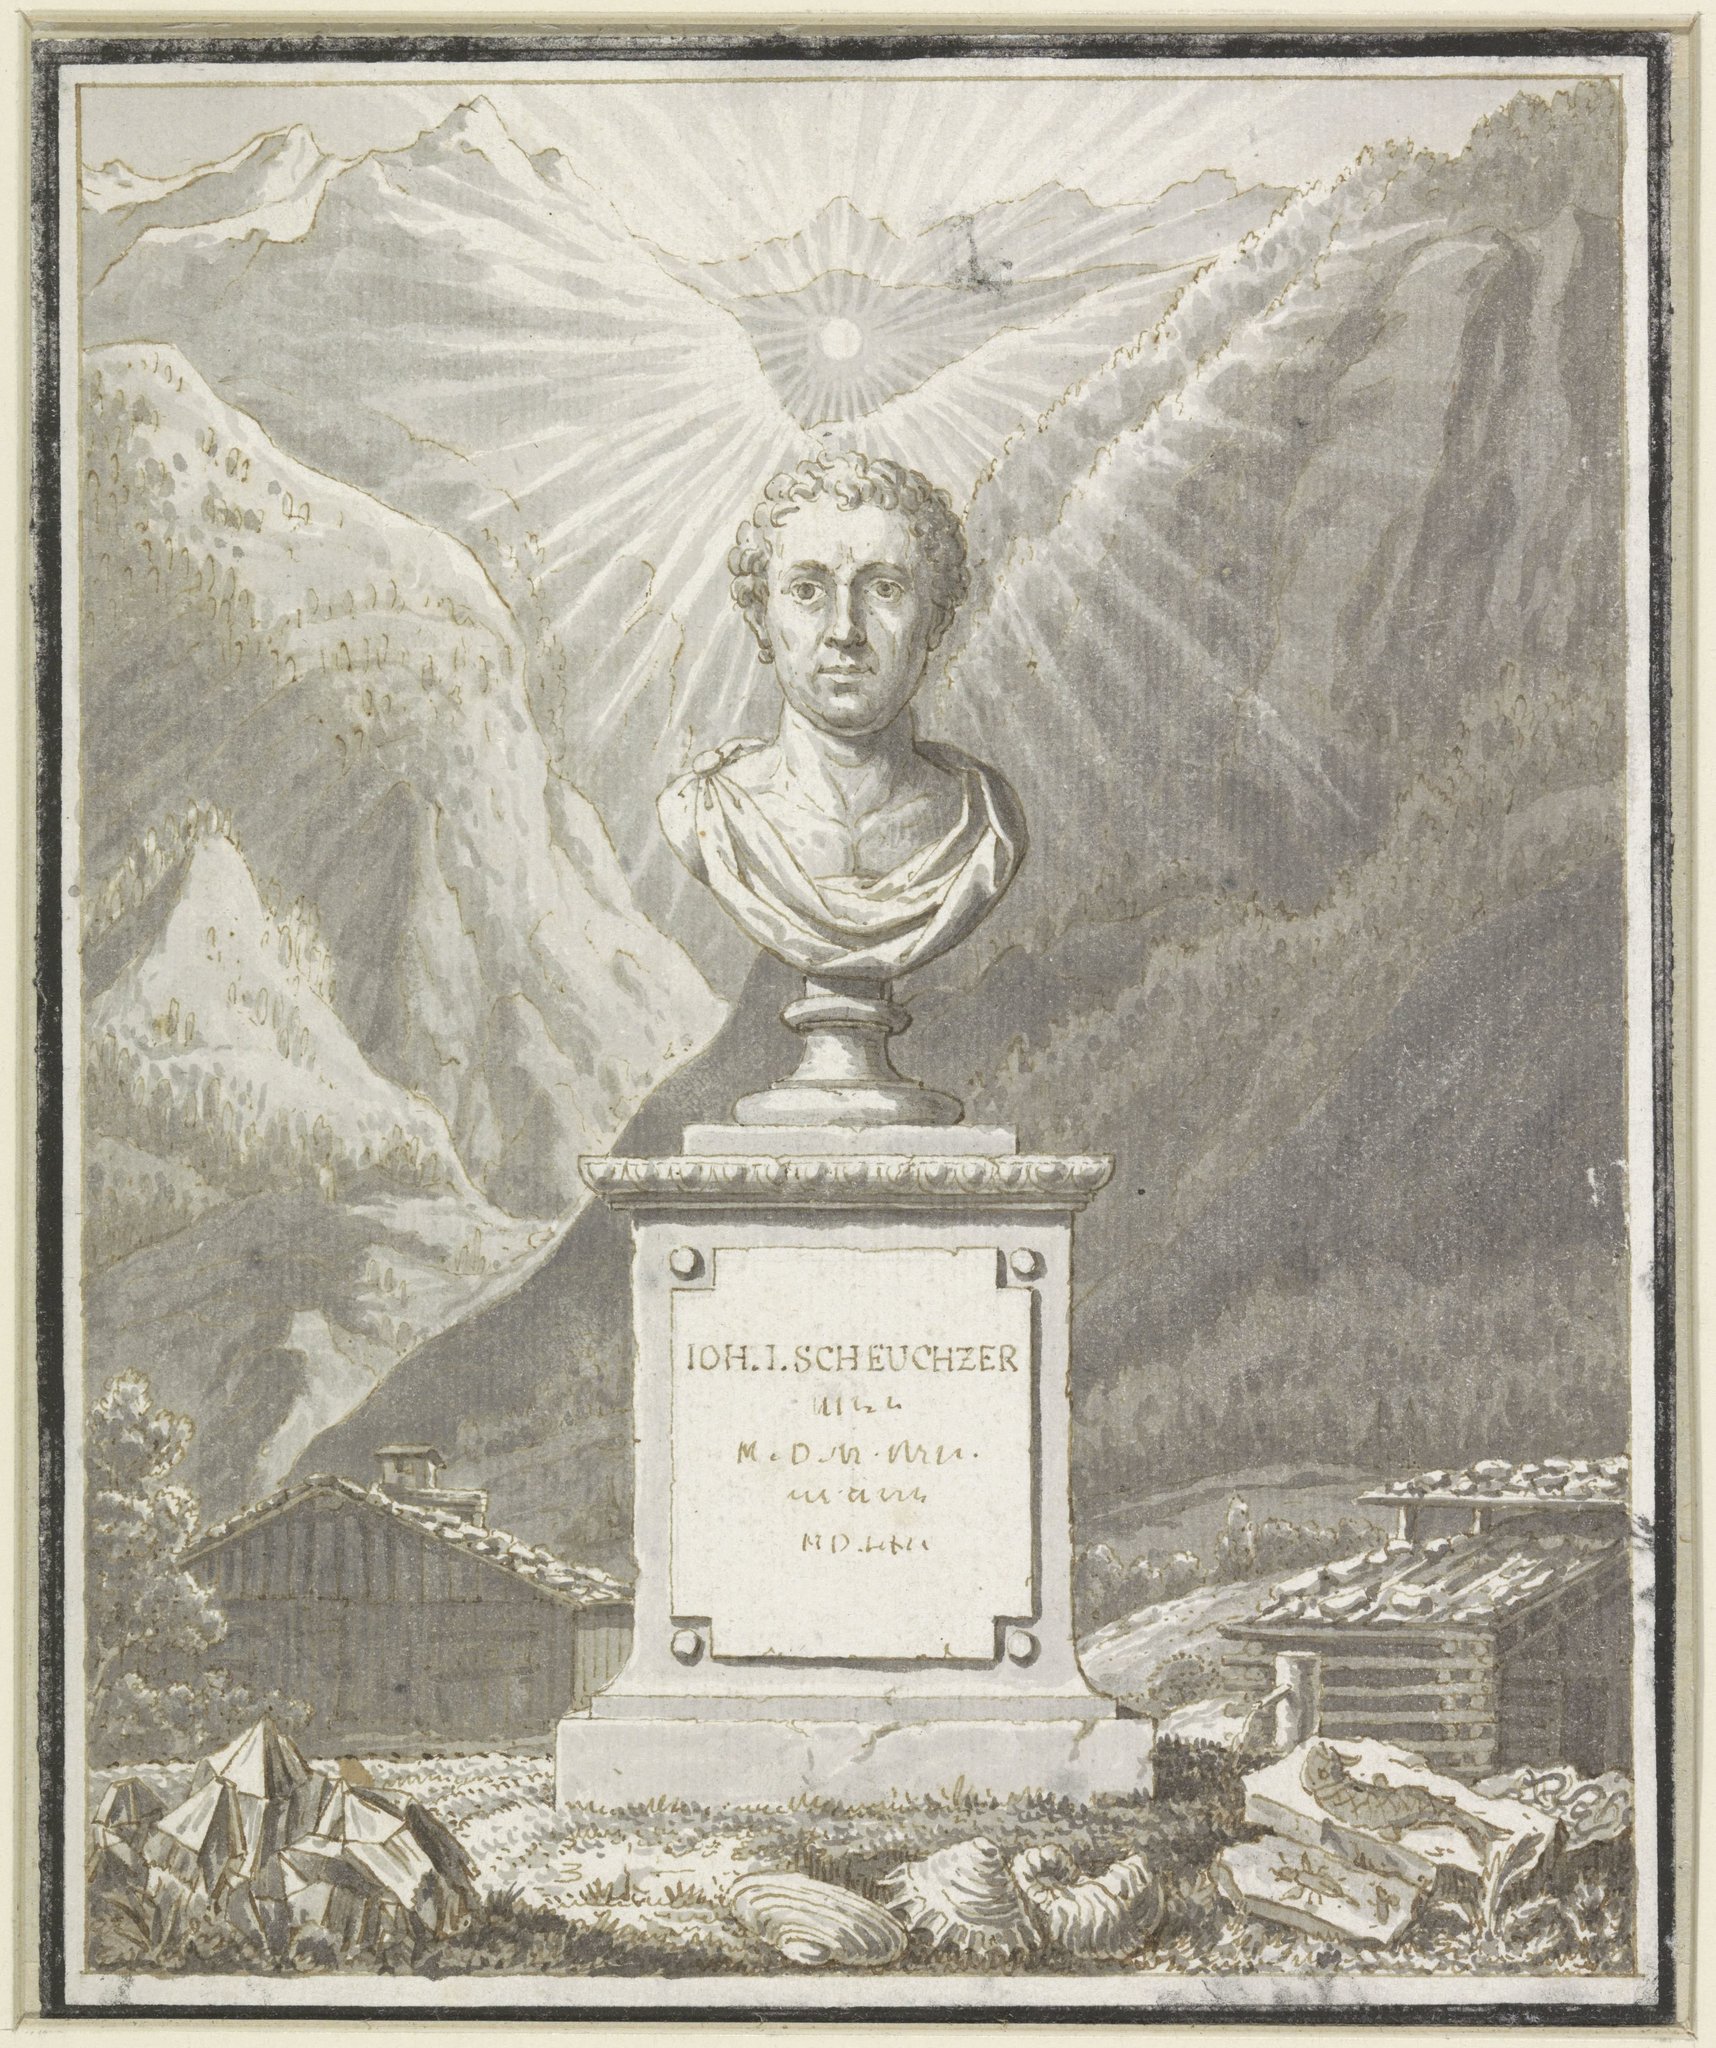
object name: drawing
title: Portretbuste van Johann Jakob Scheuchzer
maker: Anonymous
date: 1733-1800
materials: ink, paper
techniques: brush, pen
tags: johann jakob scheuchzer, fossil animals, crystals, historical persons, mountain-range, snow peaks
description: Portretbuste van Johann Jakob Scheuchzer, wetenschapper, in een berglandschap.